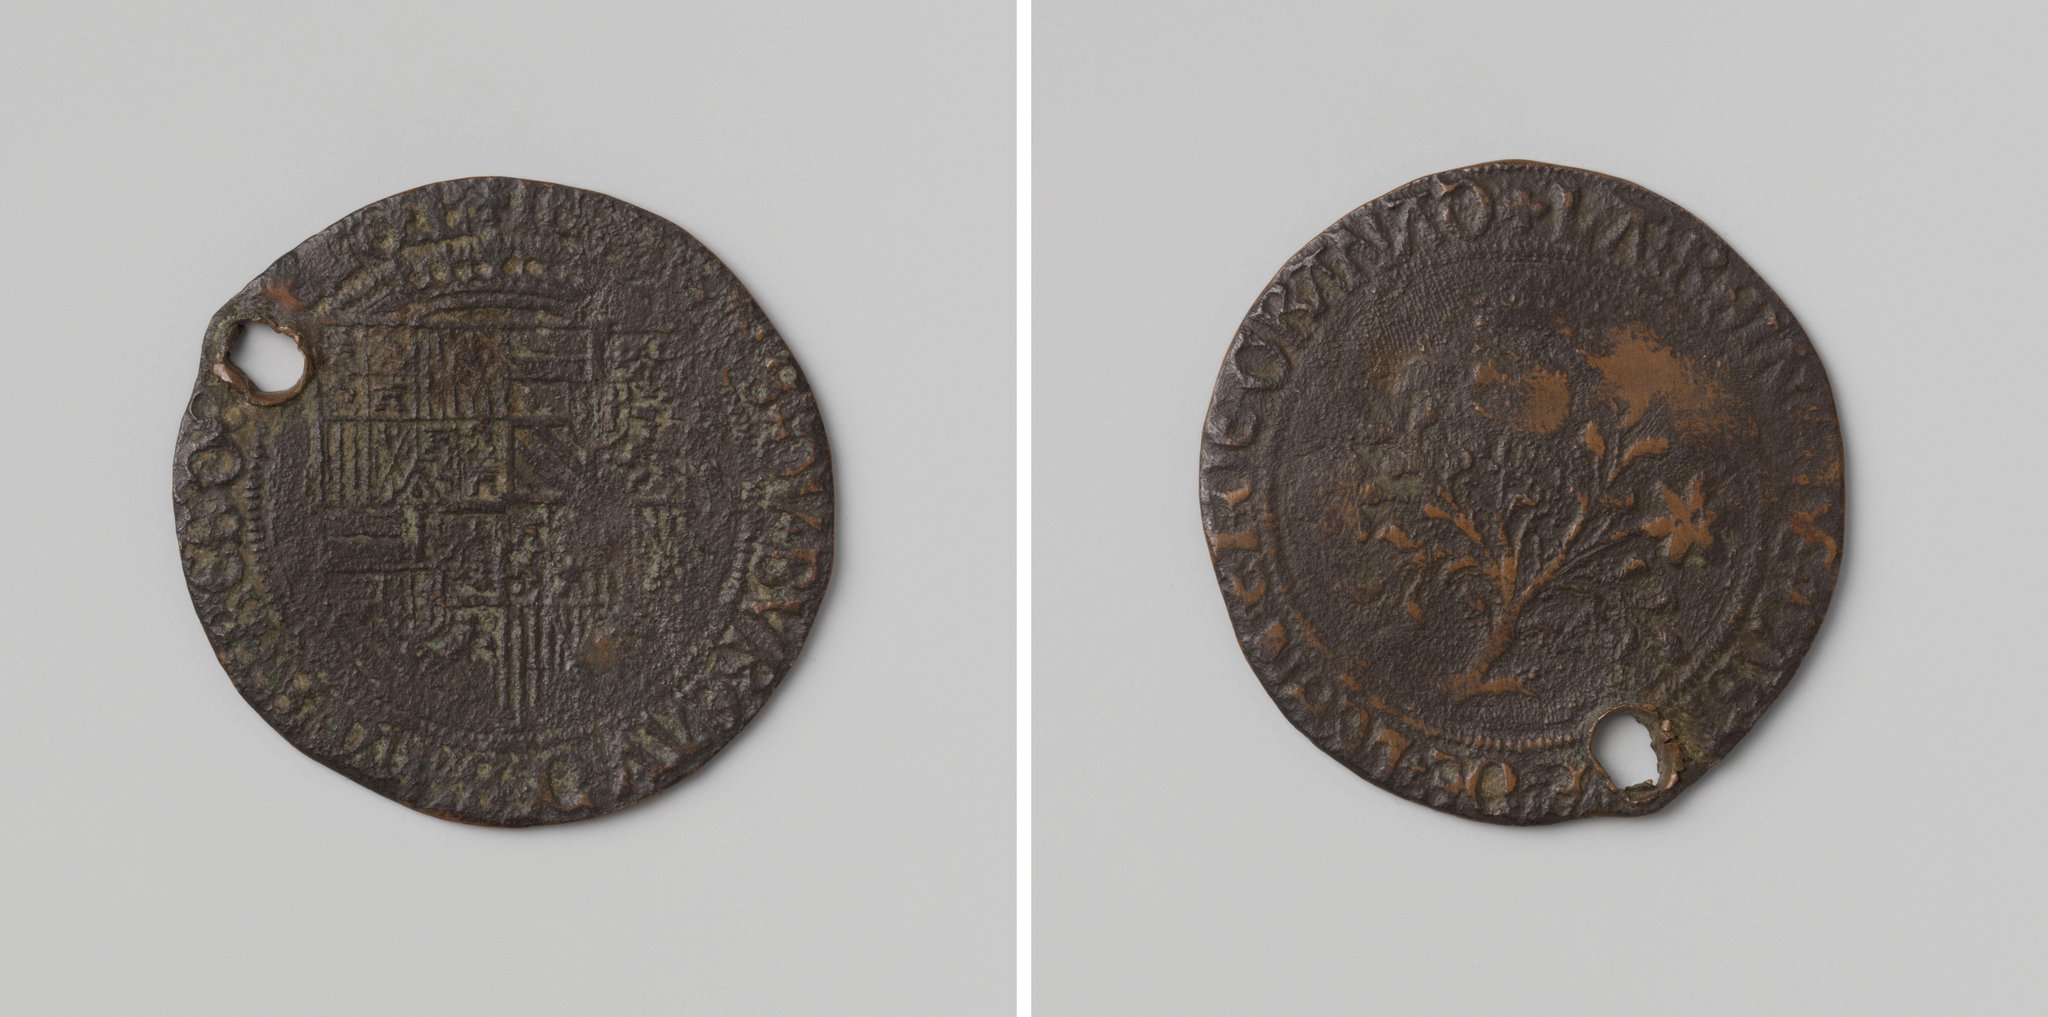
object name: jeton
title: Johanna, koningin van Castilie, rekenpenning geslagen op last van de rekenkamer der hofmeesters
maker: Anonymous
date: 1506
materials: copper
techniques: striking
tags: toledo, aartshertog, johanna van castilië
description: Koperen penning met gat erin. Voorzijde: gekroond wapenschild binnen omschrift. Keerzijde: granaatappelstruik met een gekroonde vrucht binnen omschrift